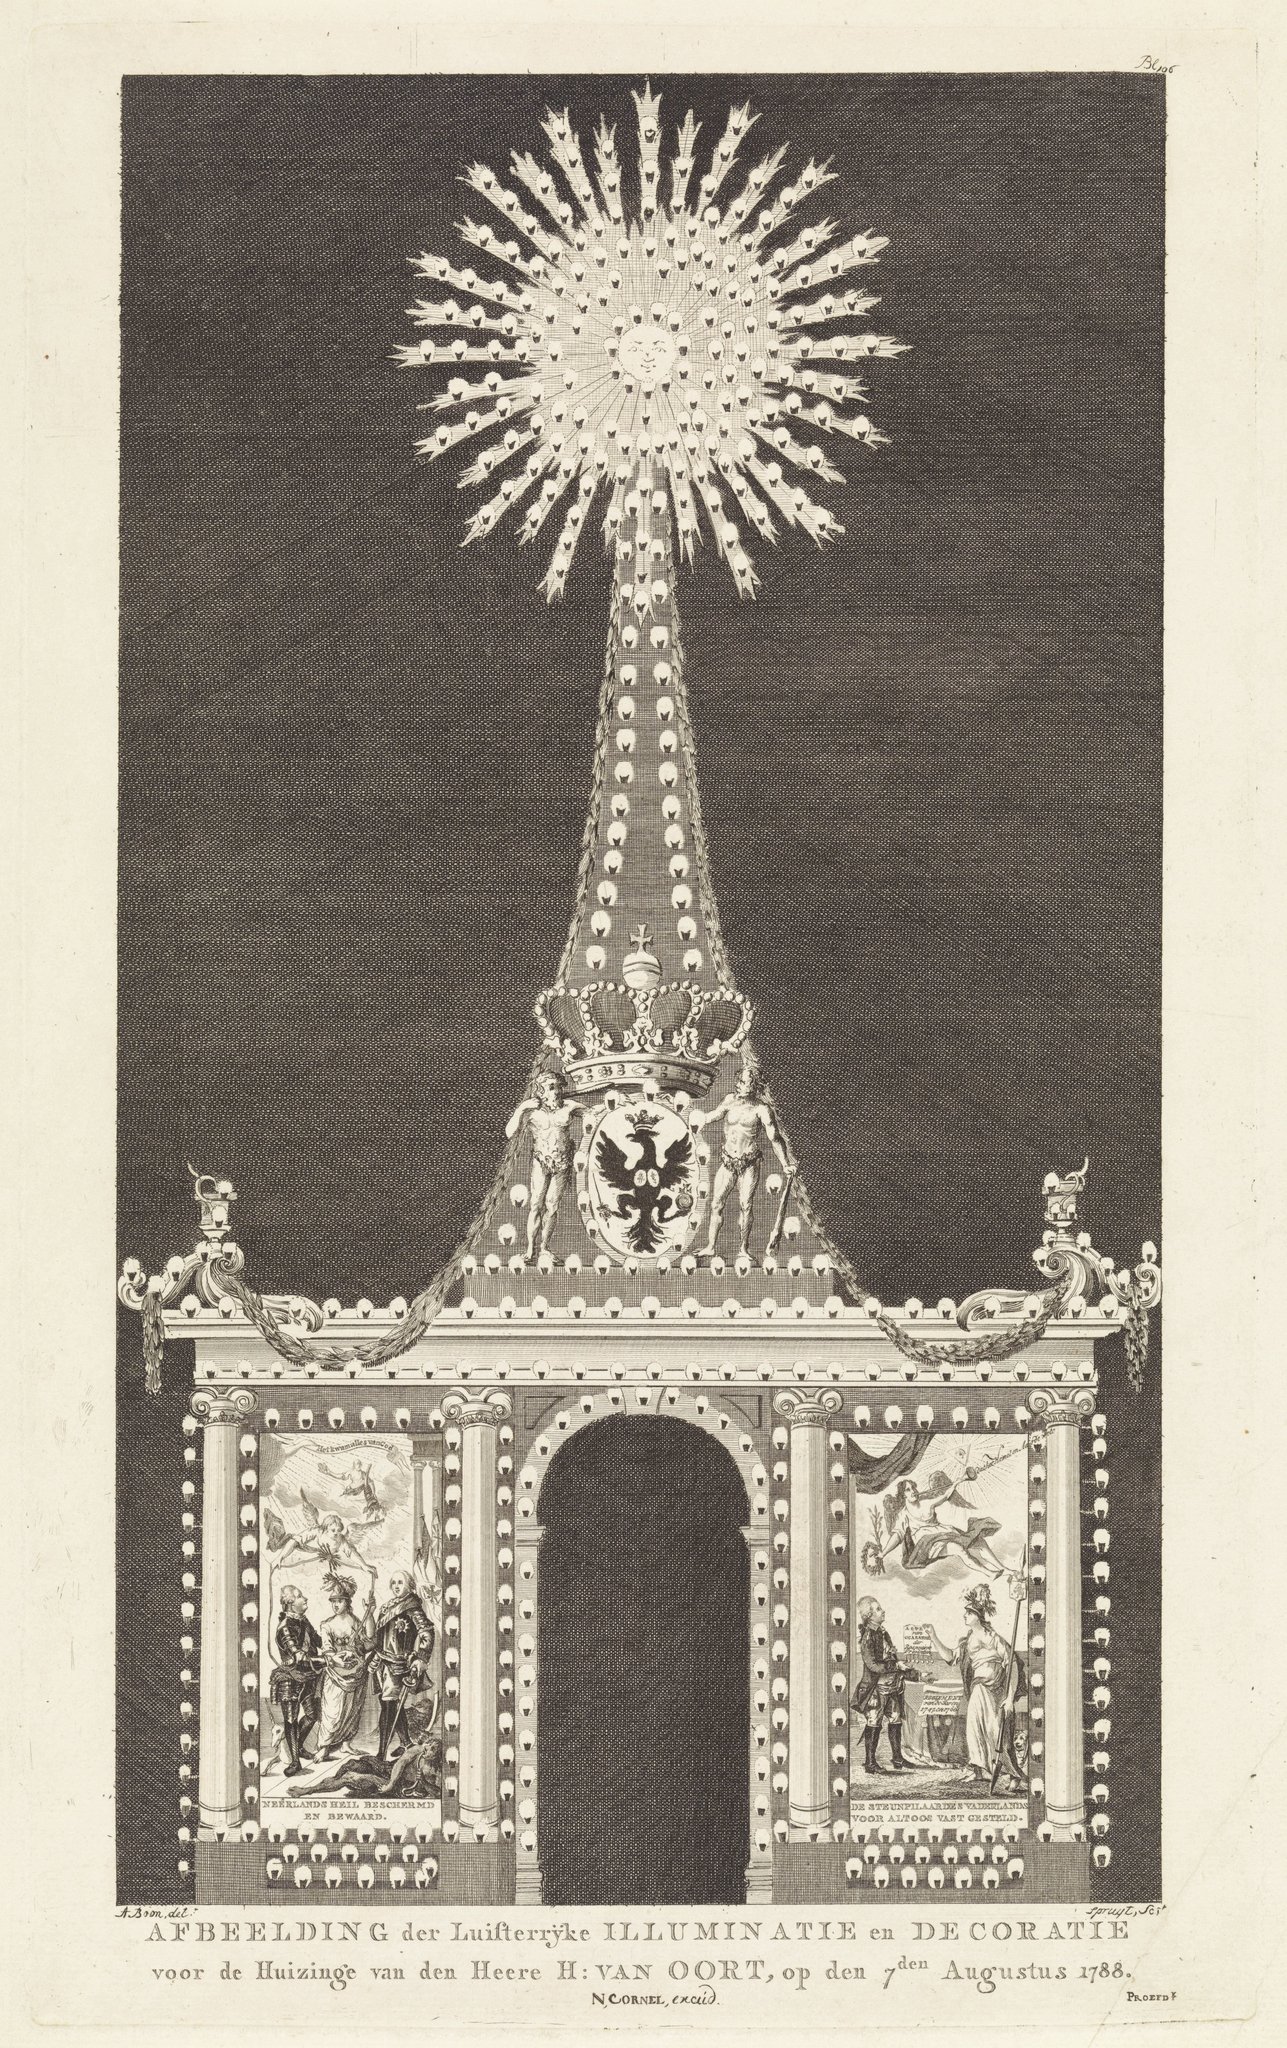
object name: print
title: Afbeelding der Luisterrijke Illuminatie en Decoratie voor de Huizinge van den Heere H: van Oort, op den 7den Augustus 1788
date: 1788-1790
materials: paper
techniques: etching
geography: rotterdam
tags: public festivities at other royal events, not meant or mentioned above (+ illumination, fire-works ~ festive activities), rotterdam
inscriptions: collector's mark: Lugt 2760, collector's mark: Lugt 2228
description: Gebruikt als illustratie in: Nicolaas Cornel, Verheerlykt en verlicht Rotterdam, of Beschryving der plechtige illuminatien en decoratien, welken (...) hebben plaats gehad, op den 7e. augustus 1788. Rotterdam: Nicolaas Cornel, 1789.